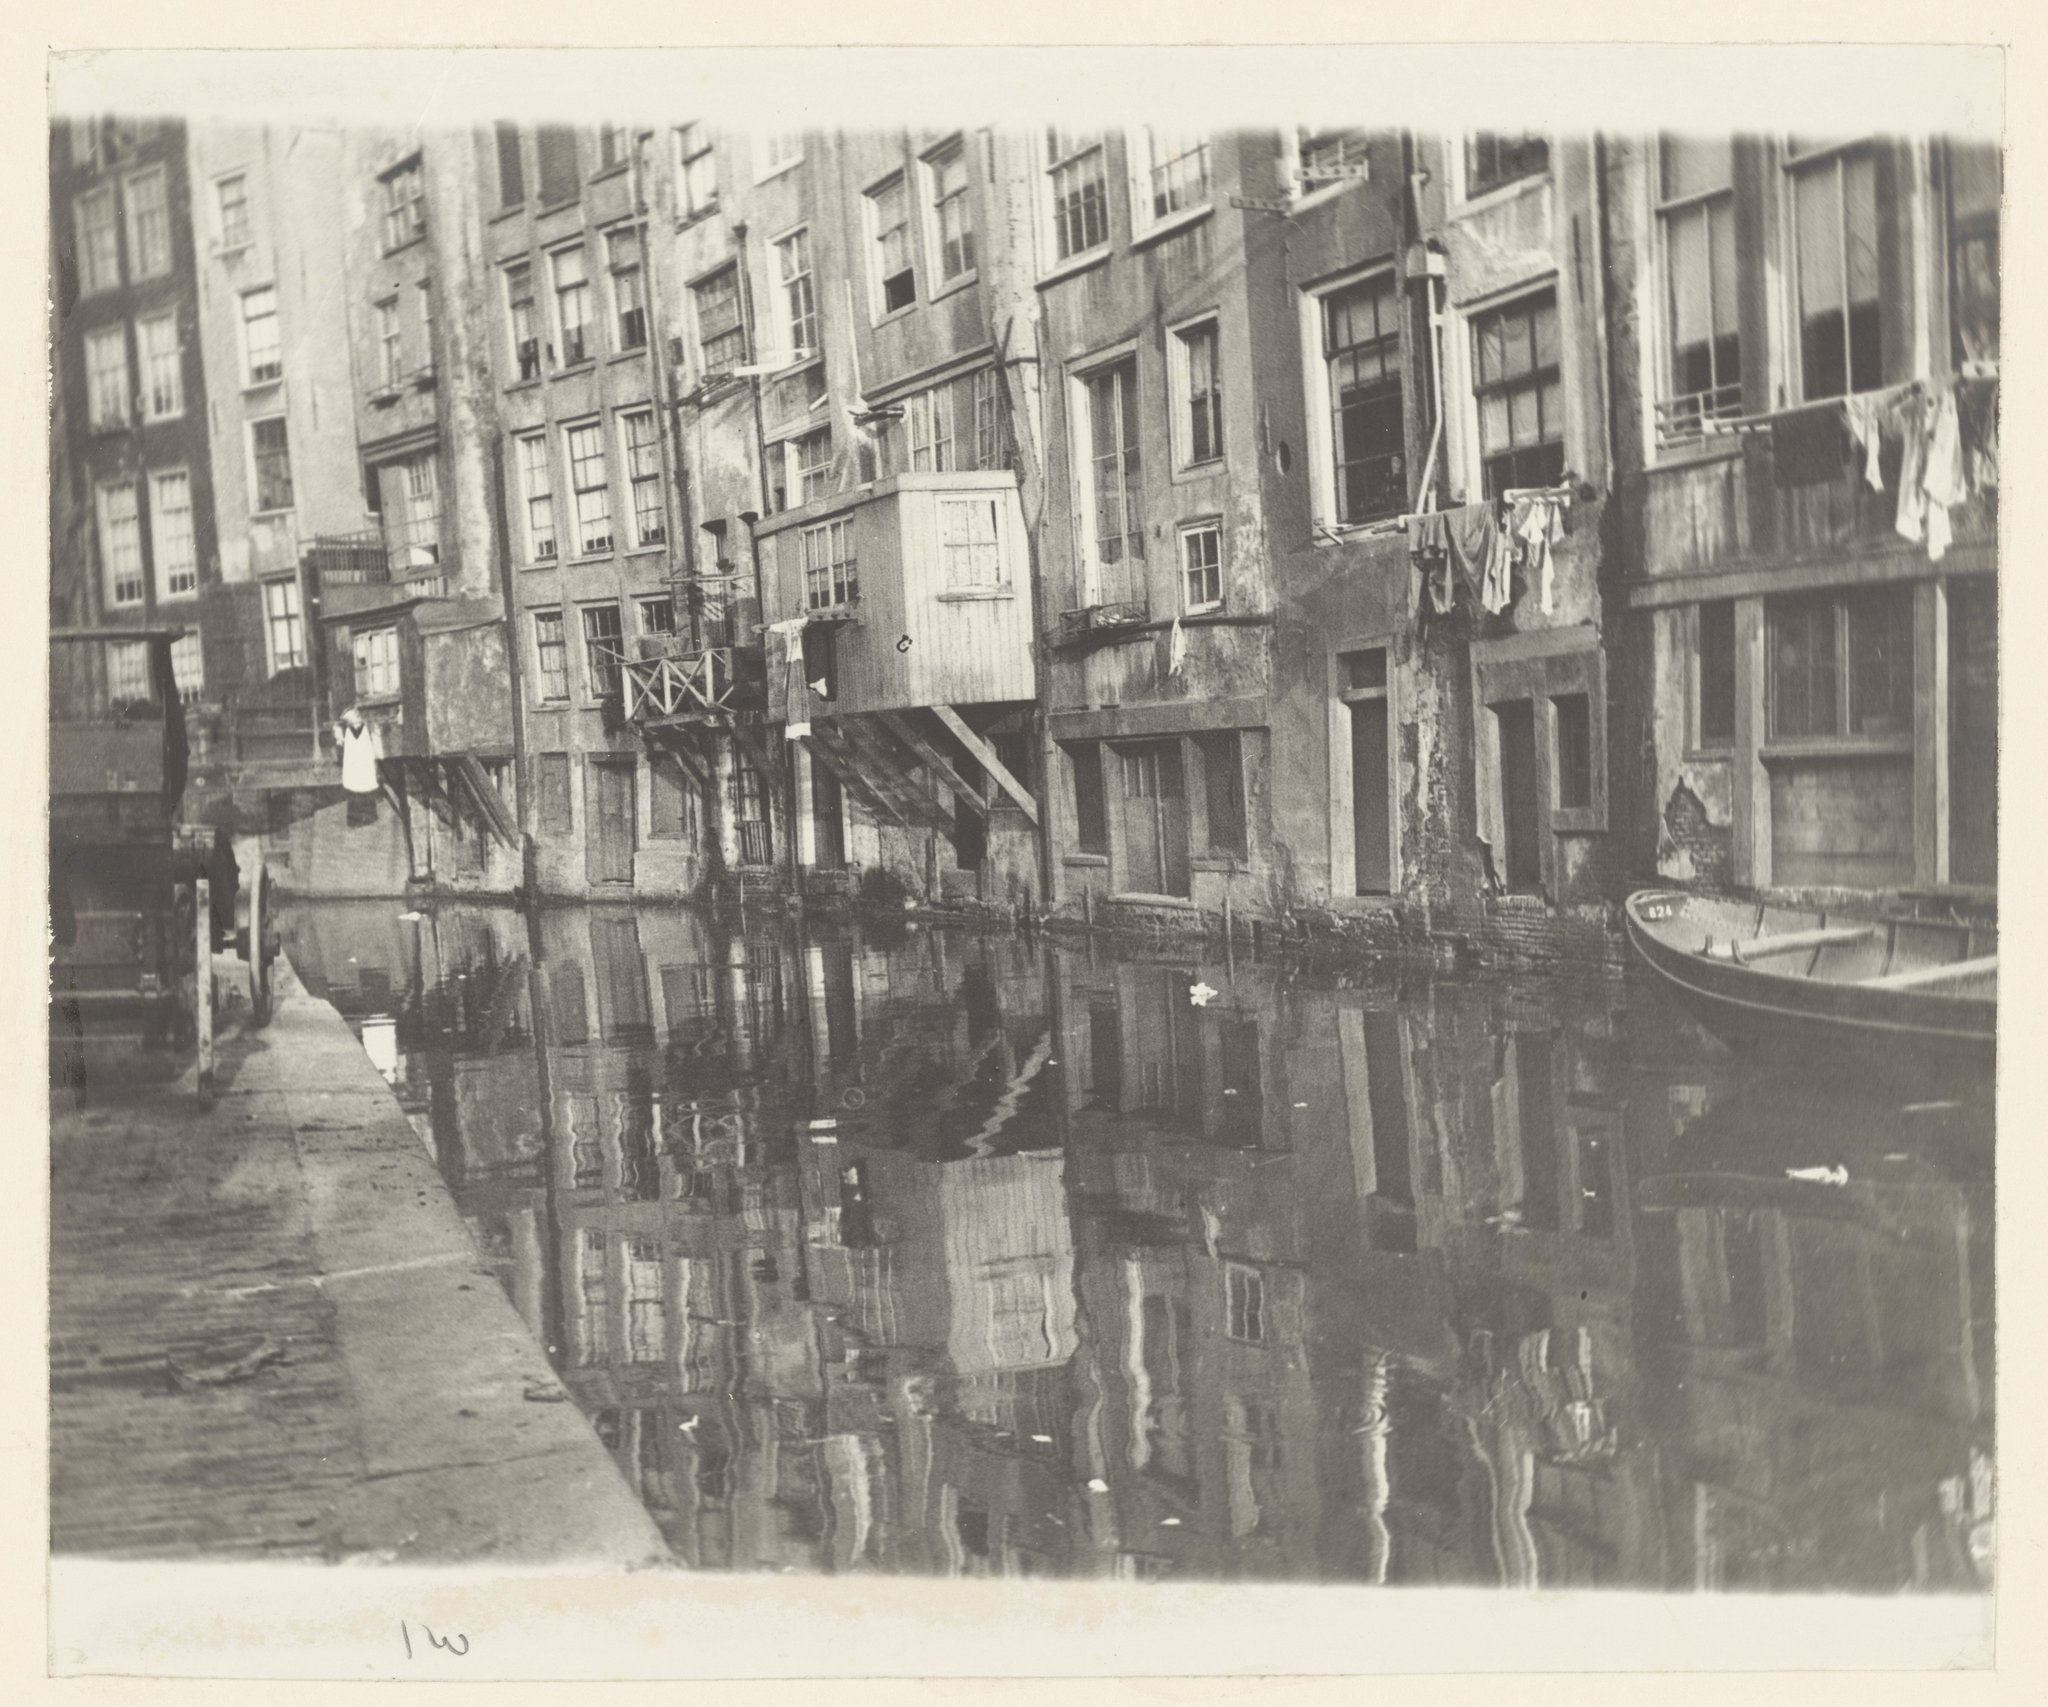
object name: photograph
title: Gezicht op de Oudezijds Achterburgwal en de achterzijde van de Zeedijk in Amsterdam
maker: george hendrik breitner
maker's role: draughtsman, painter, print maker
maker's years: 1857-1923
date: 1894-1898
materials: cardboard, paper, photographic support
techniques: gelatin silver print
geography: amsterdam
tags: canals, waters (in city), quay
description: Datering gebaseerd op cat. tent. G.H. Breitner. Fotograaf en schilder van het Amsterdamse stadsgezicht (Bussum 1997), nr. 60